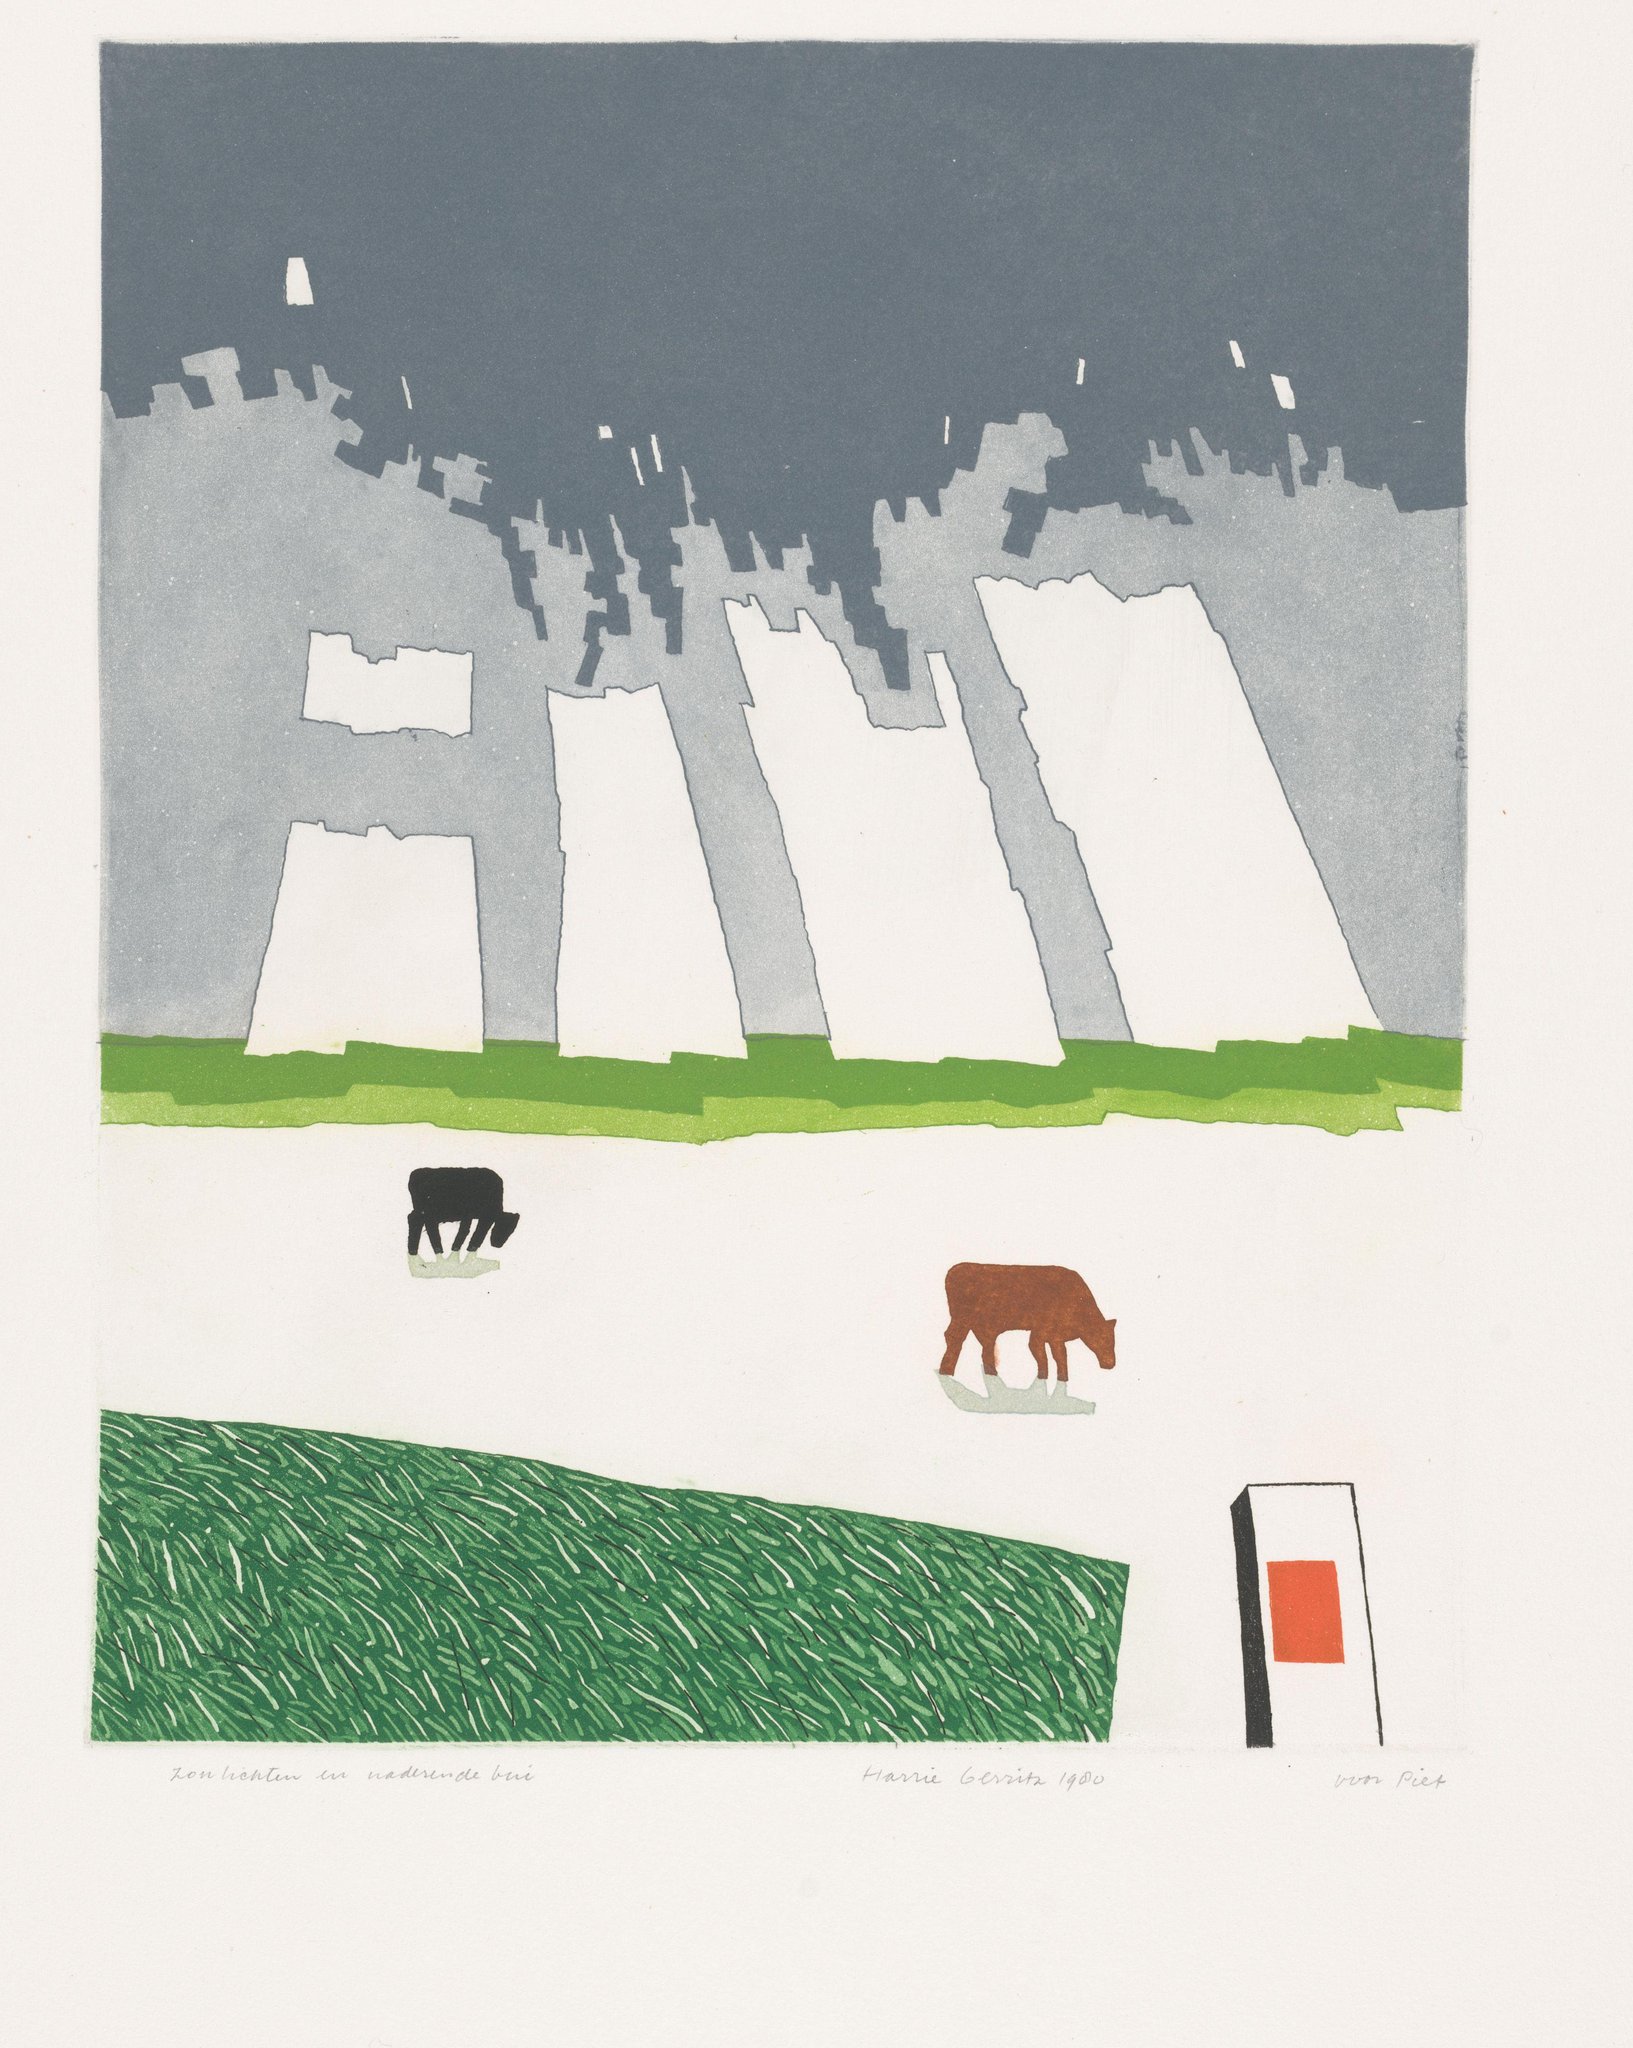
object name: print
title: Zonlichten en naderende bui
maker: harrie a. gerritz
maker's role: draughtsman, painter, print maker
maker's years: 1940-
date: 1980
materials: paper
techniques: aquatint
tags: cow, clouds, landscapes in the temperate zone, sunlight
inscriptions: dedication: ‘voor Piet’, collector's mark: Lugt 2228